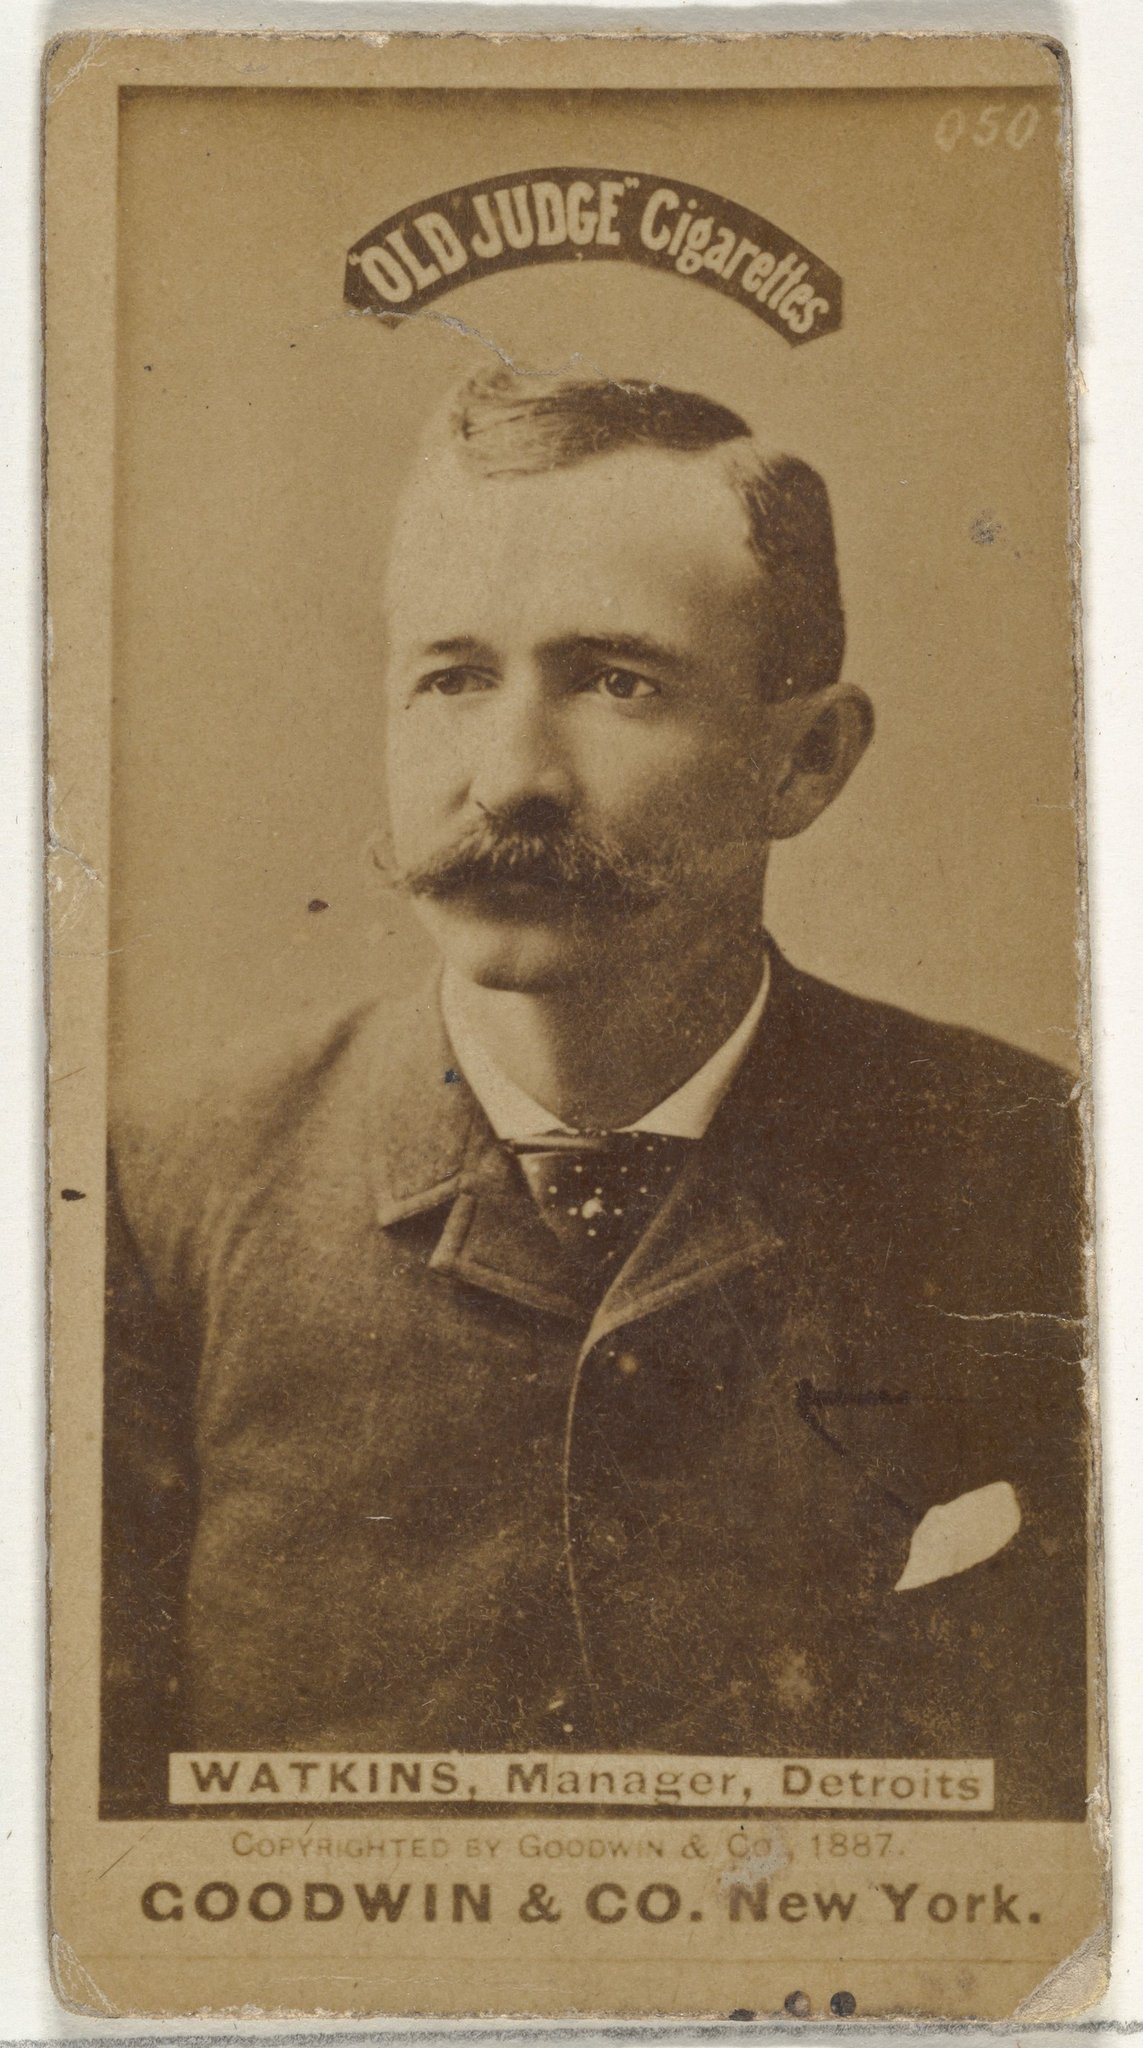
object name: baseball card, photograph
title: William Henry "Wattie" Watkins, Manager, Detroit Wolverines, from the Old Judge series (N172) for Old Judge Cigarettes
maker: goodwin & company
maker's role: publisher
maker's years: 1850-1950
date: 1887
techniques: albumen silver print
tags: men,portraits,baseball,athletes